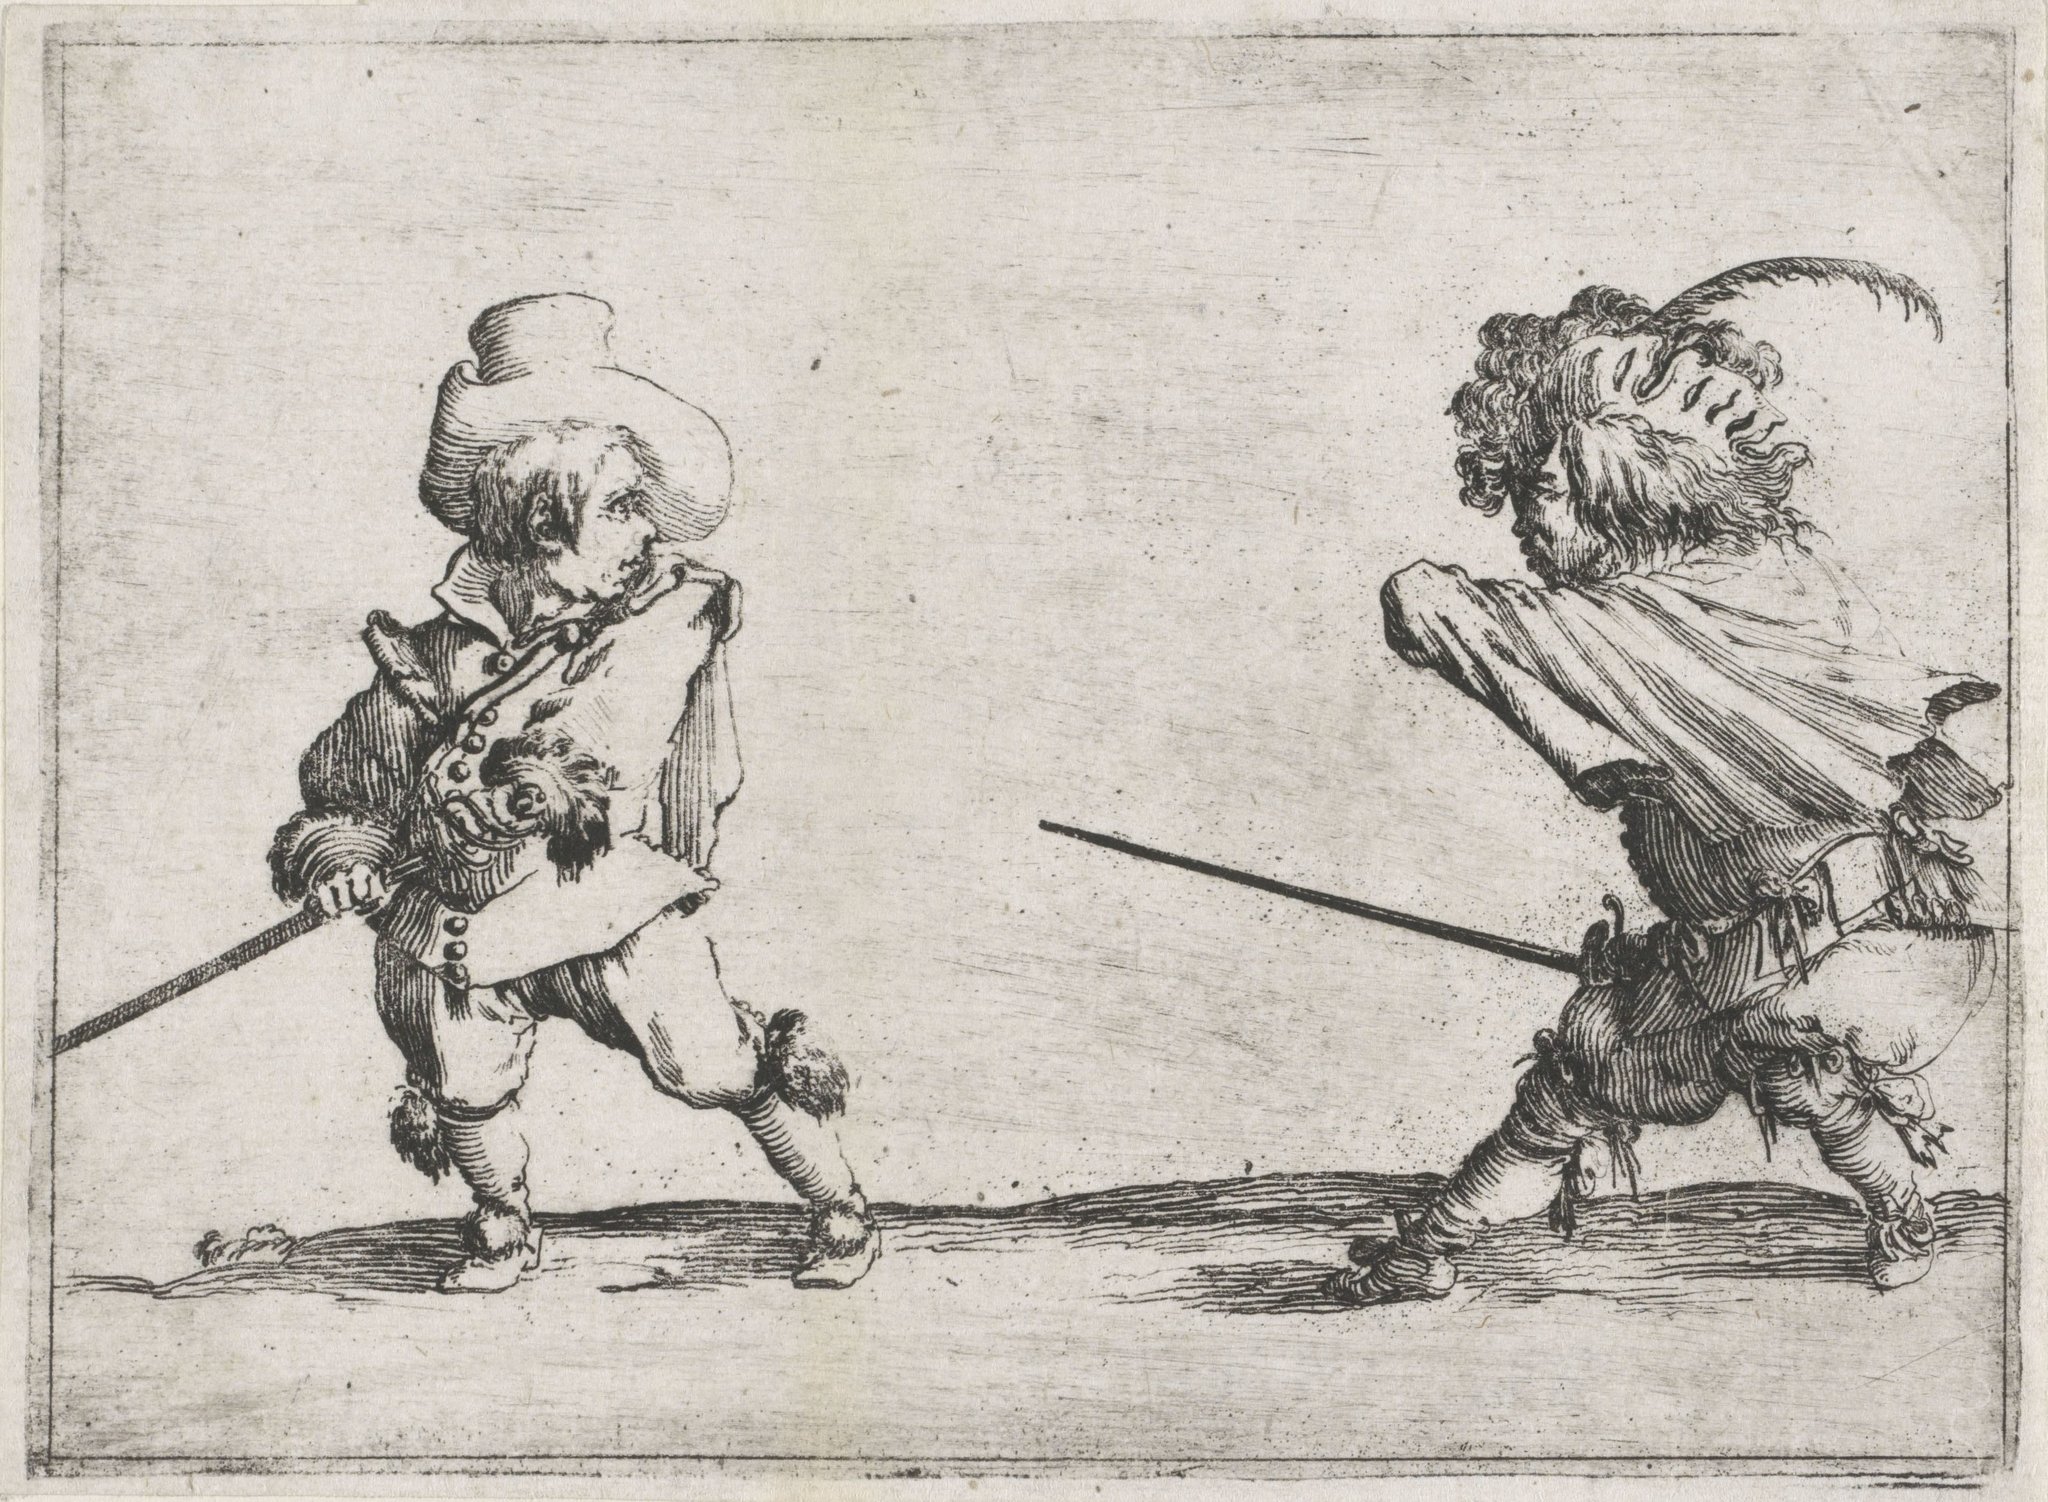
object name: print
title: Komische taferelen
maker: stefano della bella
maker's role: draughtsman, print maker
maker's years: 1610-1664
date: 1620-1664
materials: paper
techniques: etching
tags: sabre (~ fencing), little people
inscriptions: collector's mark: Lugt 240